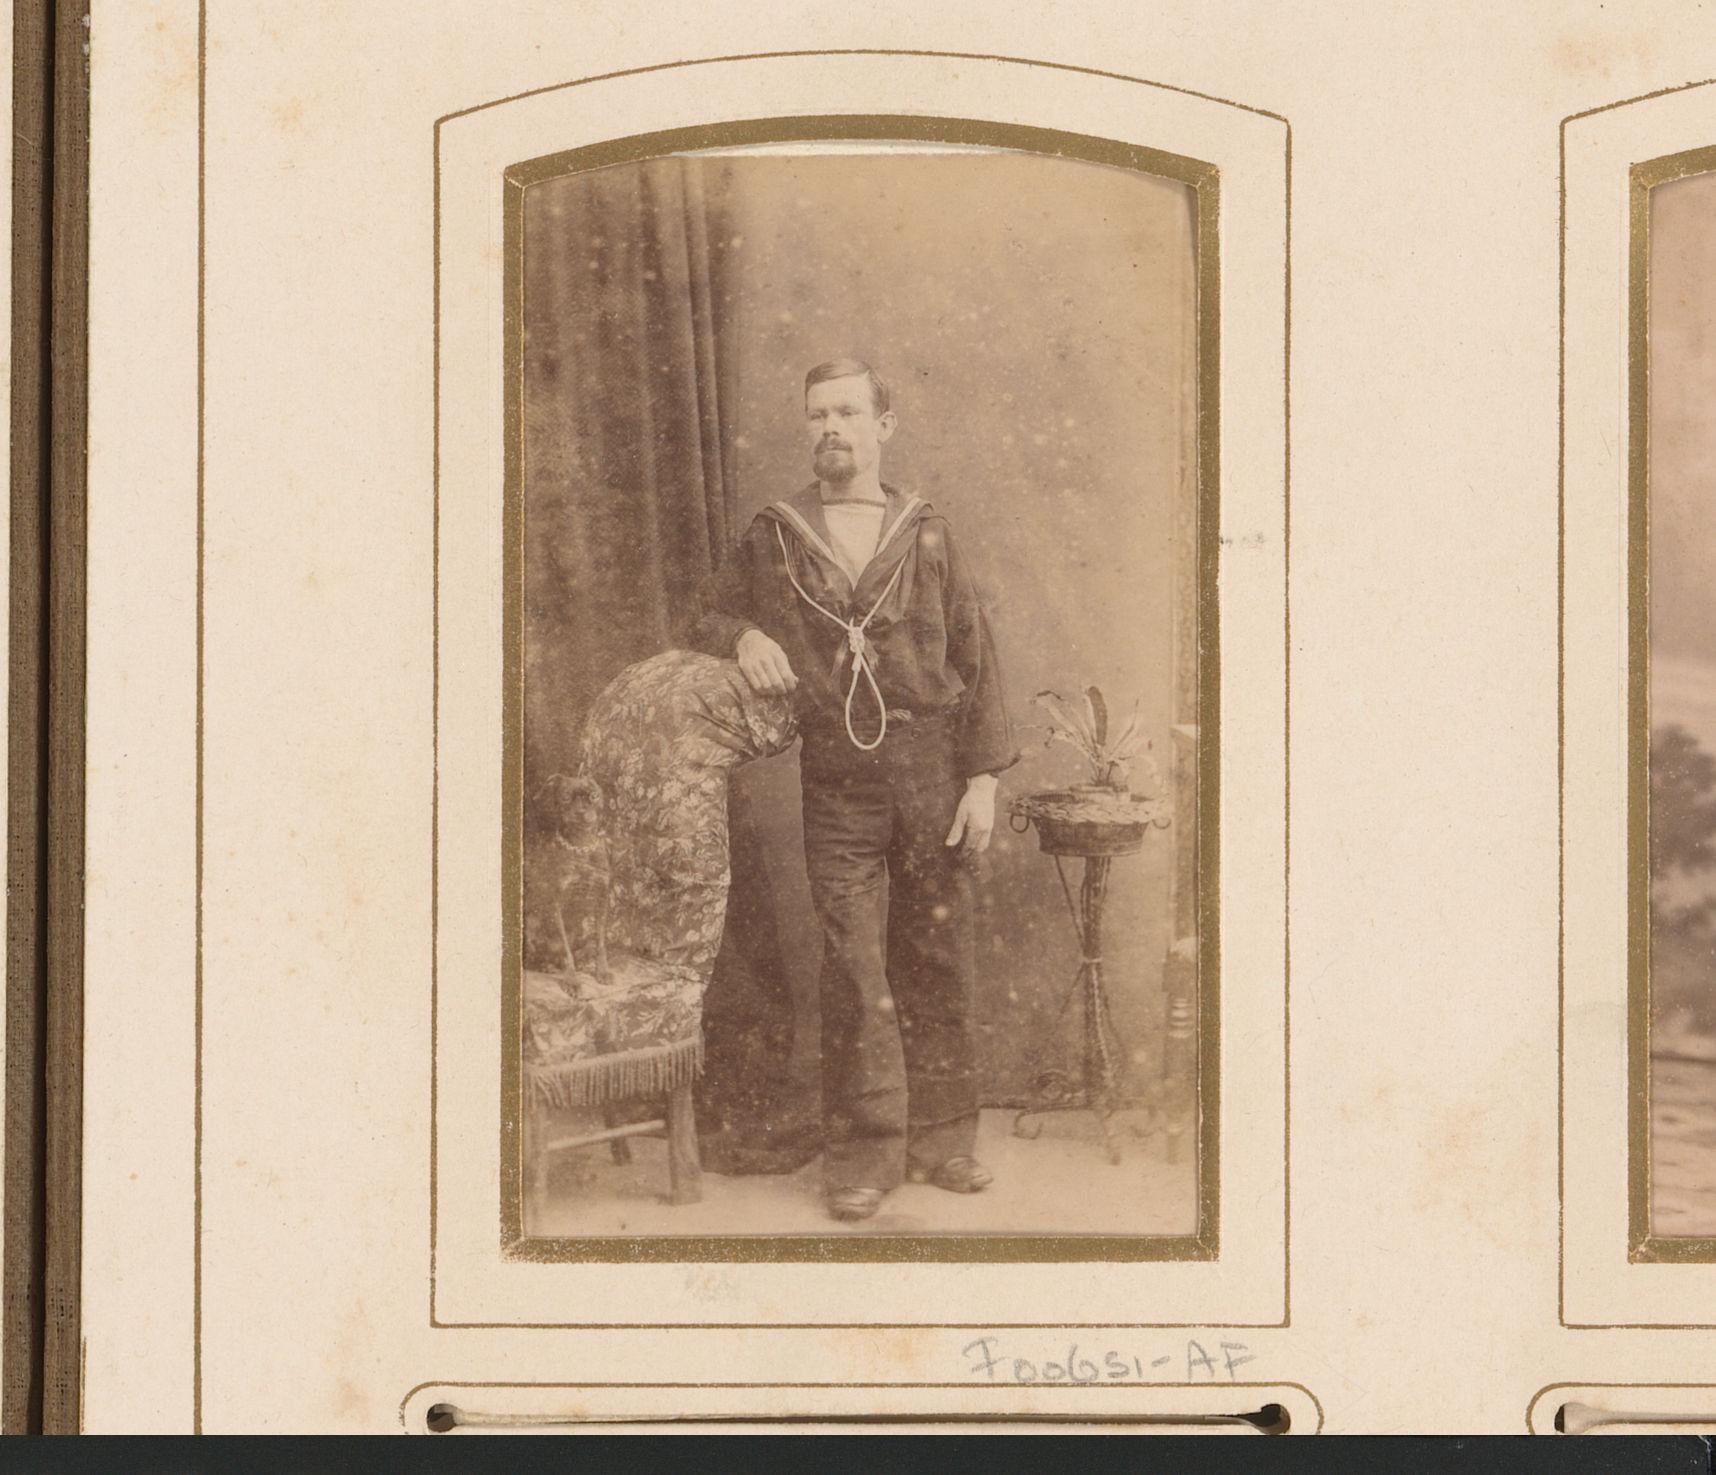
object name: album leaf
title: Portret van een matroos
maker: jesse harris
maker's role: fotograaf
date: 1880-1915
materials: cardboard, photographic support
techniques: albumen print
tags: adult man, historical persons, seaman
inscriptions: inscription: ‘83 Queen Street Portsea’